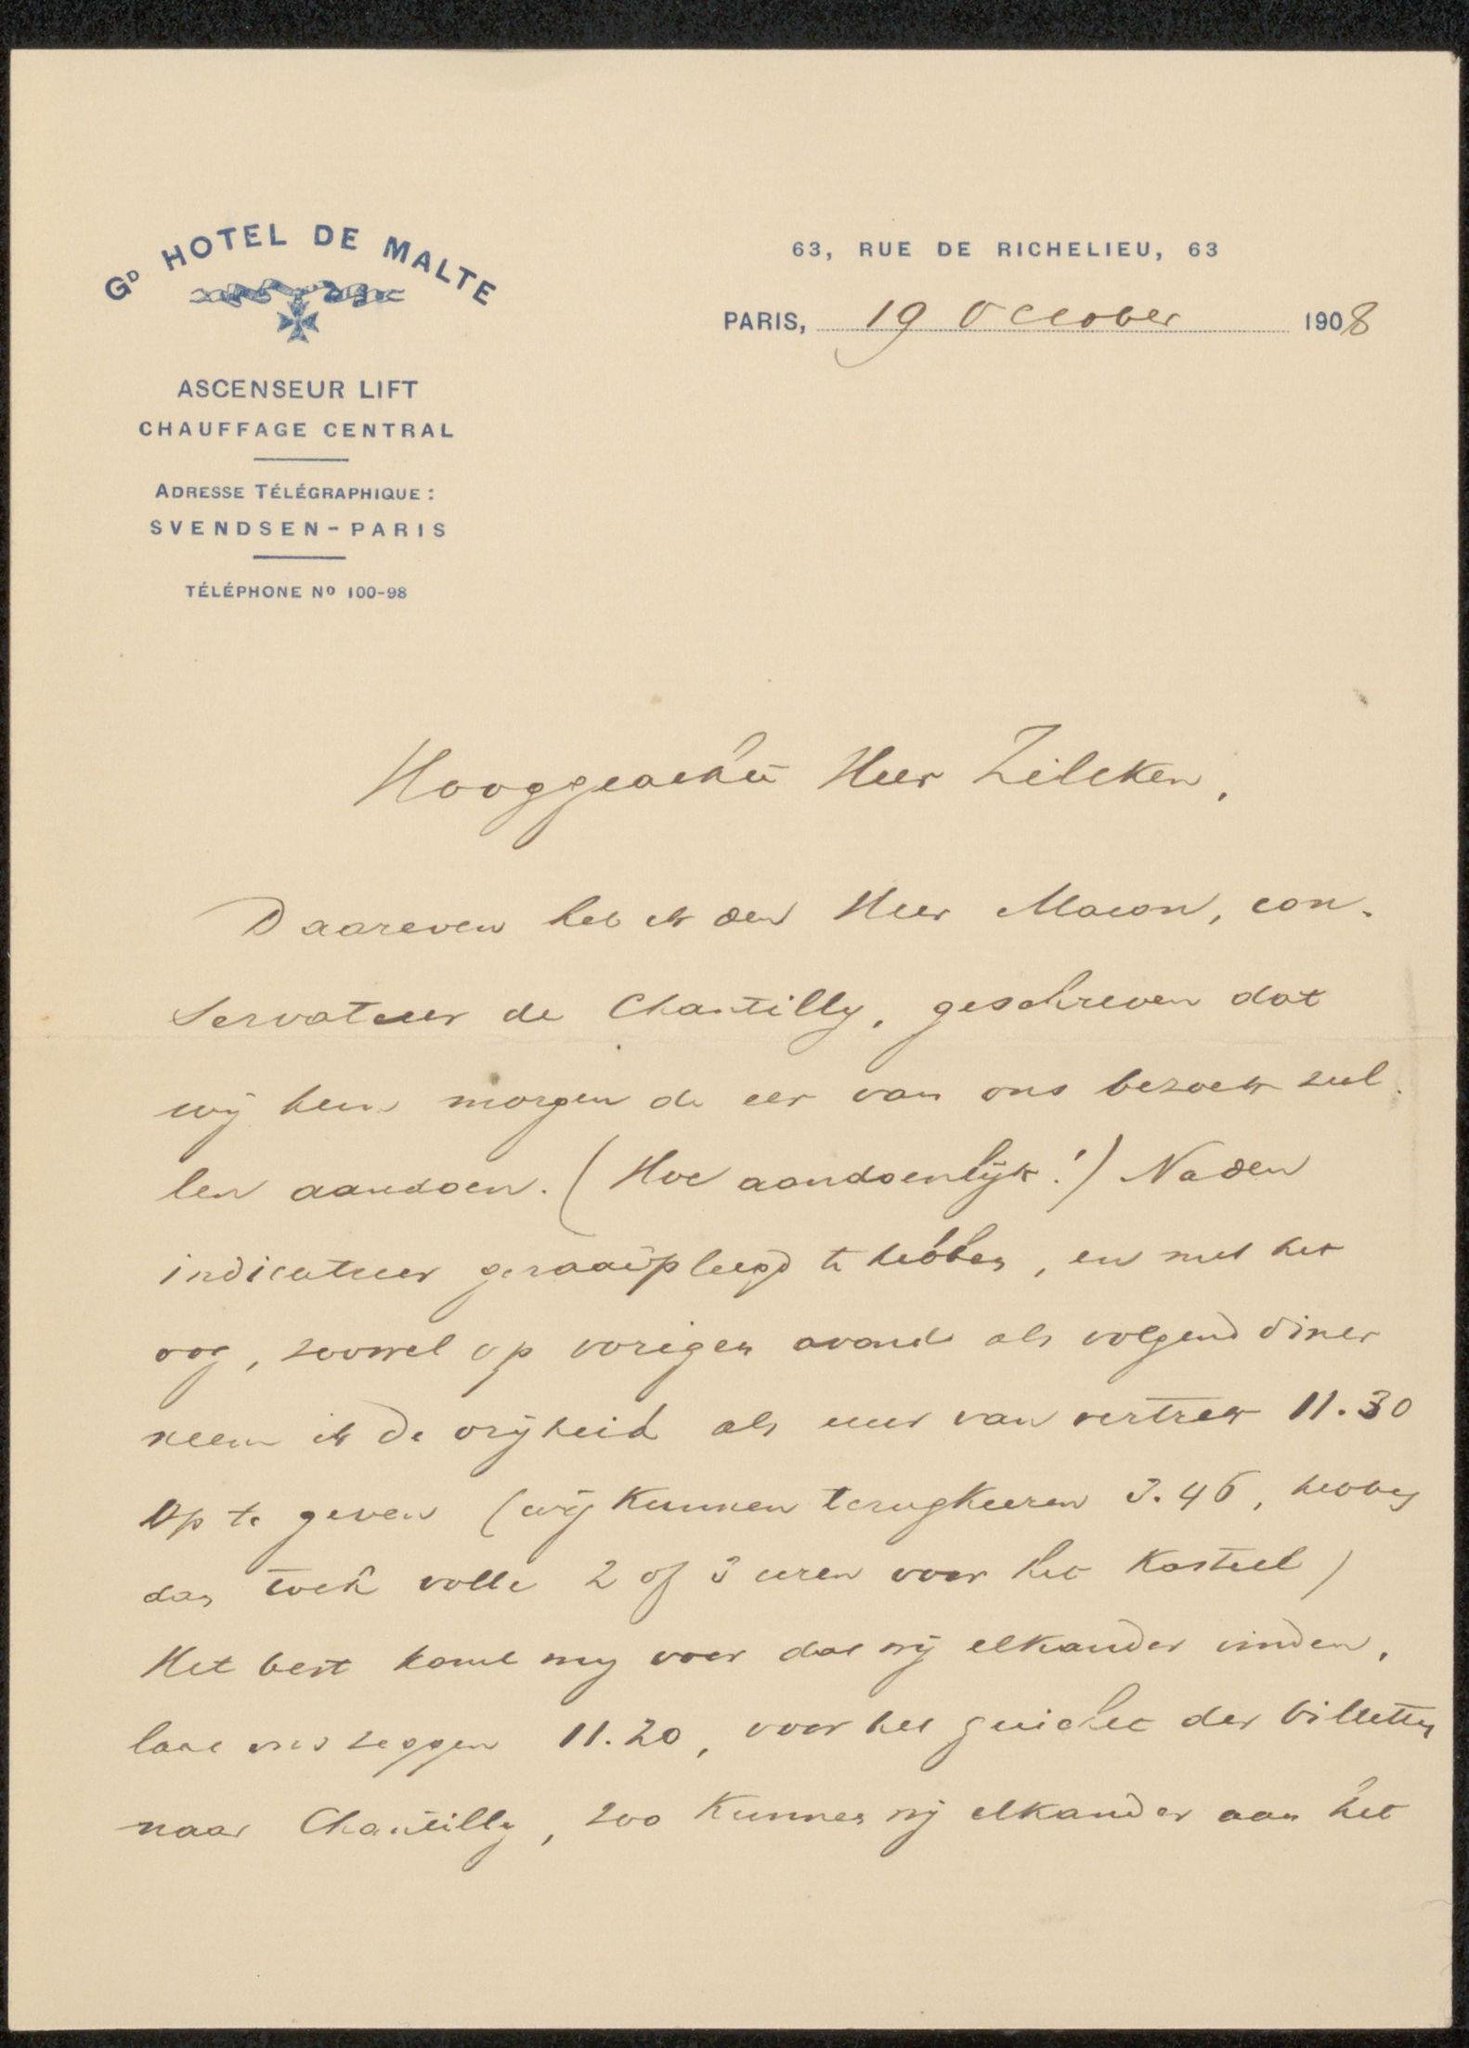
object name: letter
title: Brief aan Philip Zilcken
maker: willem byvanck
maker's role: bibliothecaris, schrijver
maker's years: 1848-1925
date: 1908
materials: ink, paper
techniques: pen, printing, writing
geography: paris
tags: painter, draughtsman, philip zilcken, chantilly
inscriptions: collector's mark: ‘RPK’, watermark: ‘CROXLEY/ LION BRAND/ J D & Co’